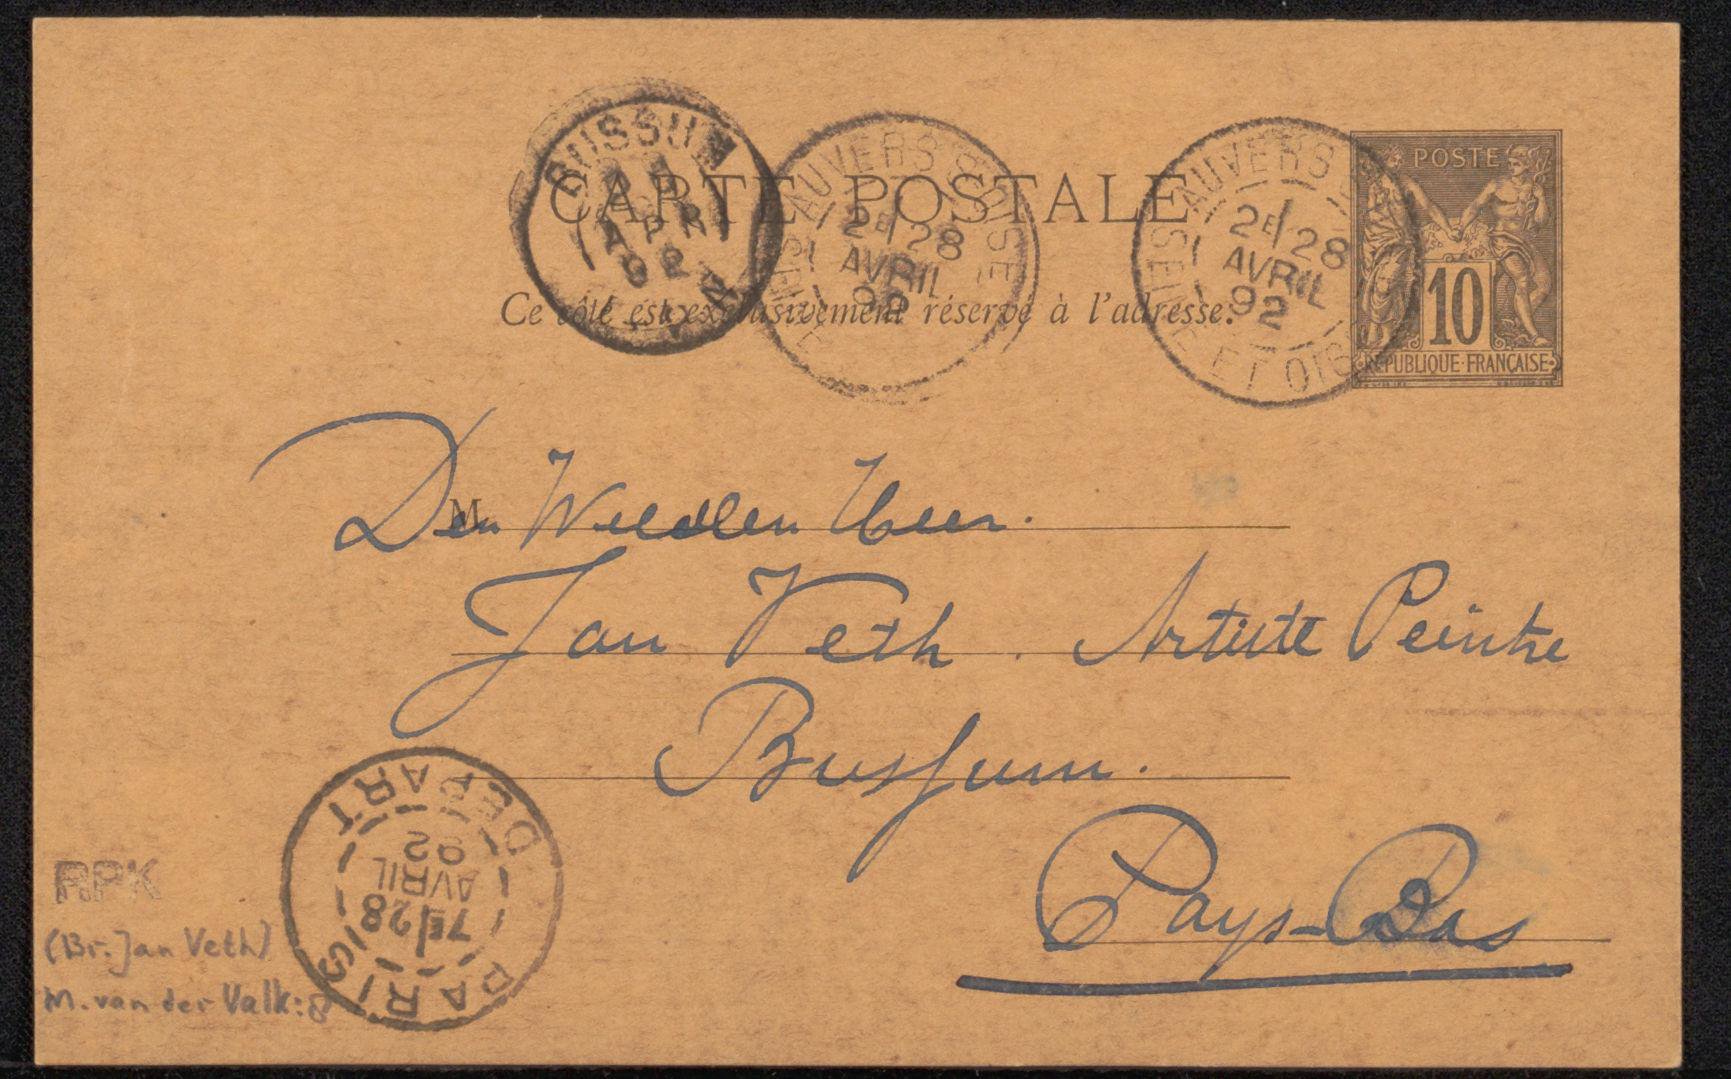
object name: postcard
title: Briefkaart aan Jan Veth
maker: maurits van der valk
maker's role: draughtsman, print maker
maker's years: 1857-1935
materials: cardboard, ink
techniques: pen, writing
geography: paris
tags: dordrecht, amsterdam, painter, print maker, draughtsman, designer, jan veth, family life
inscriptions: collector's mark: ‘RPK’